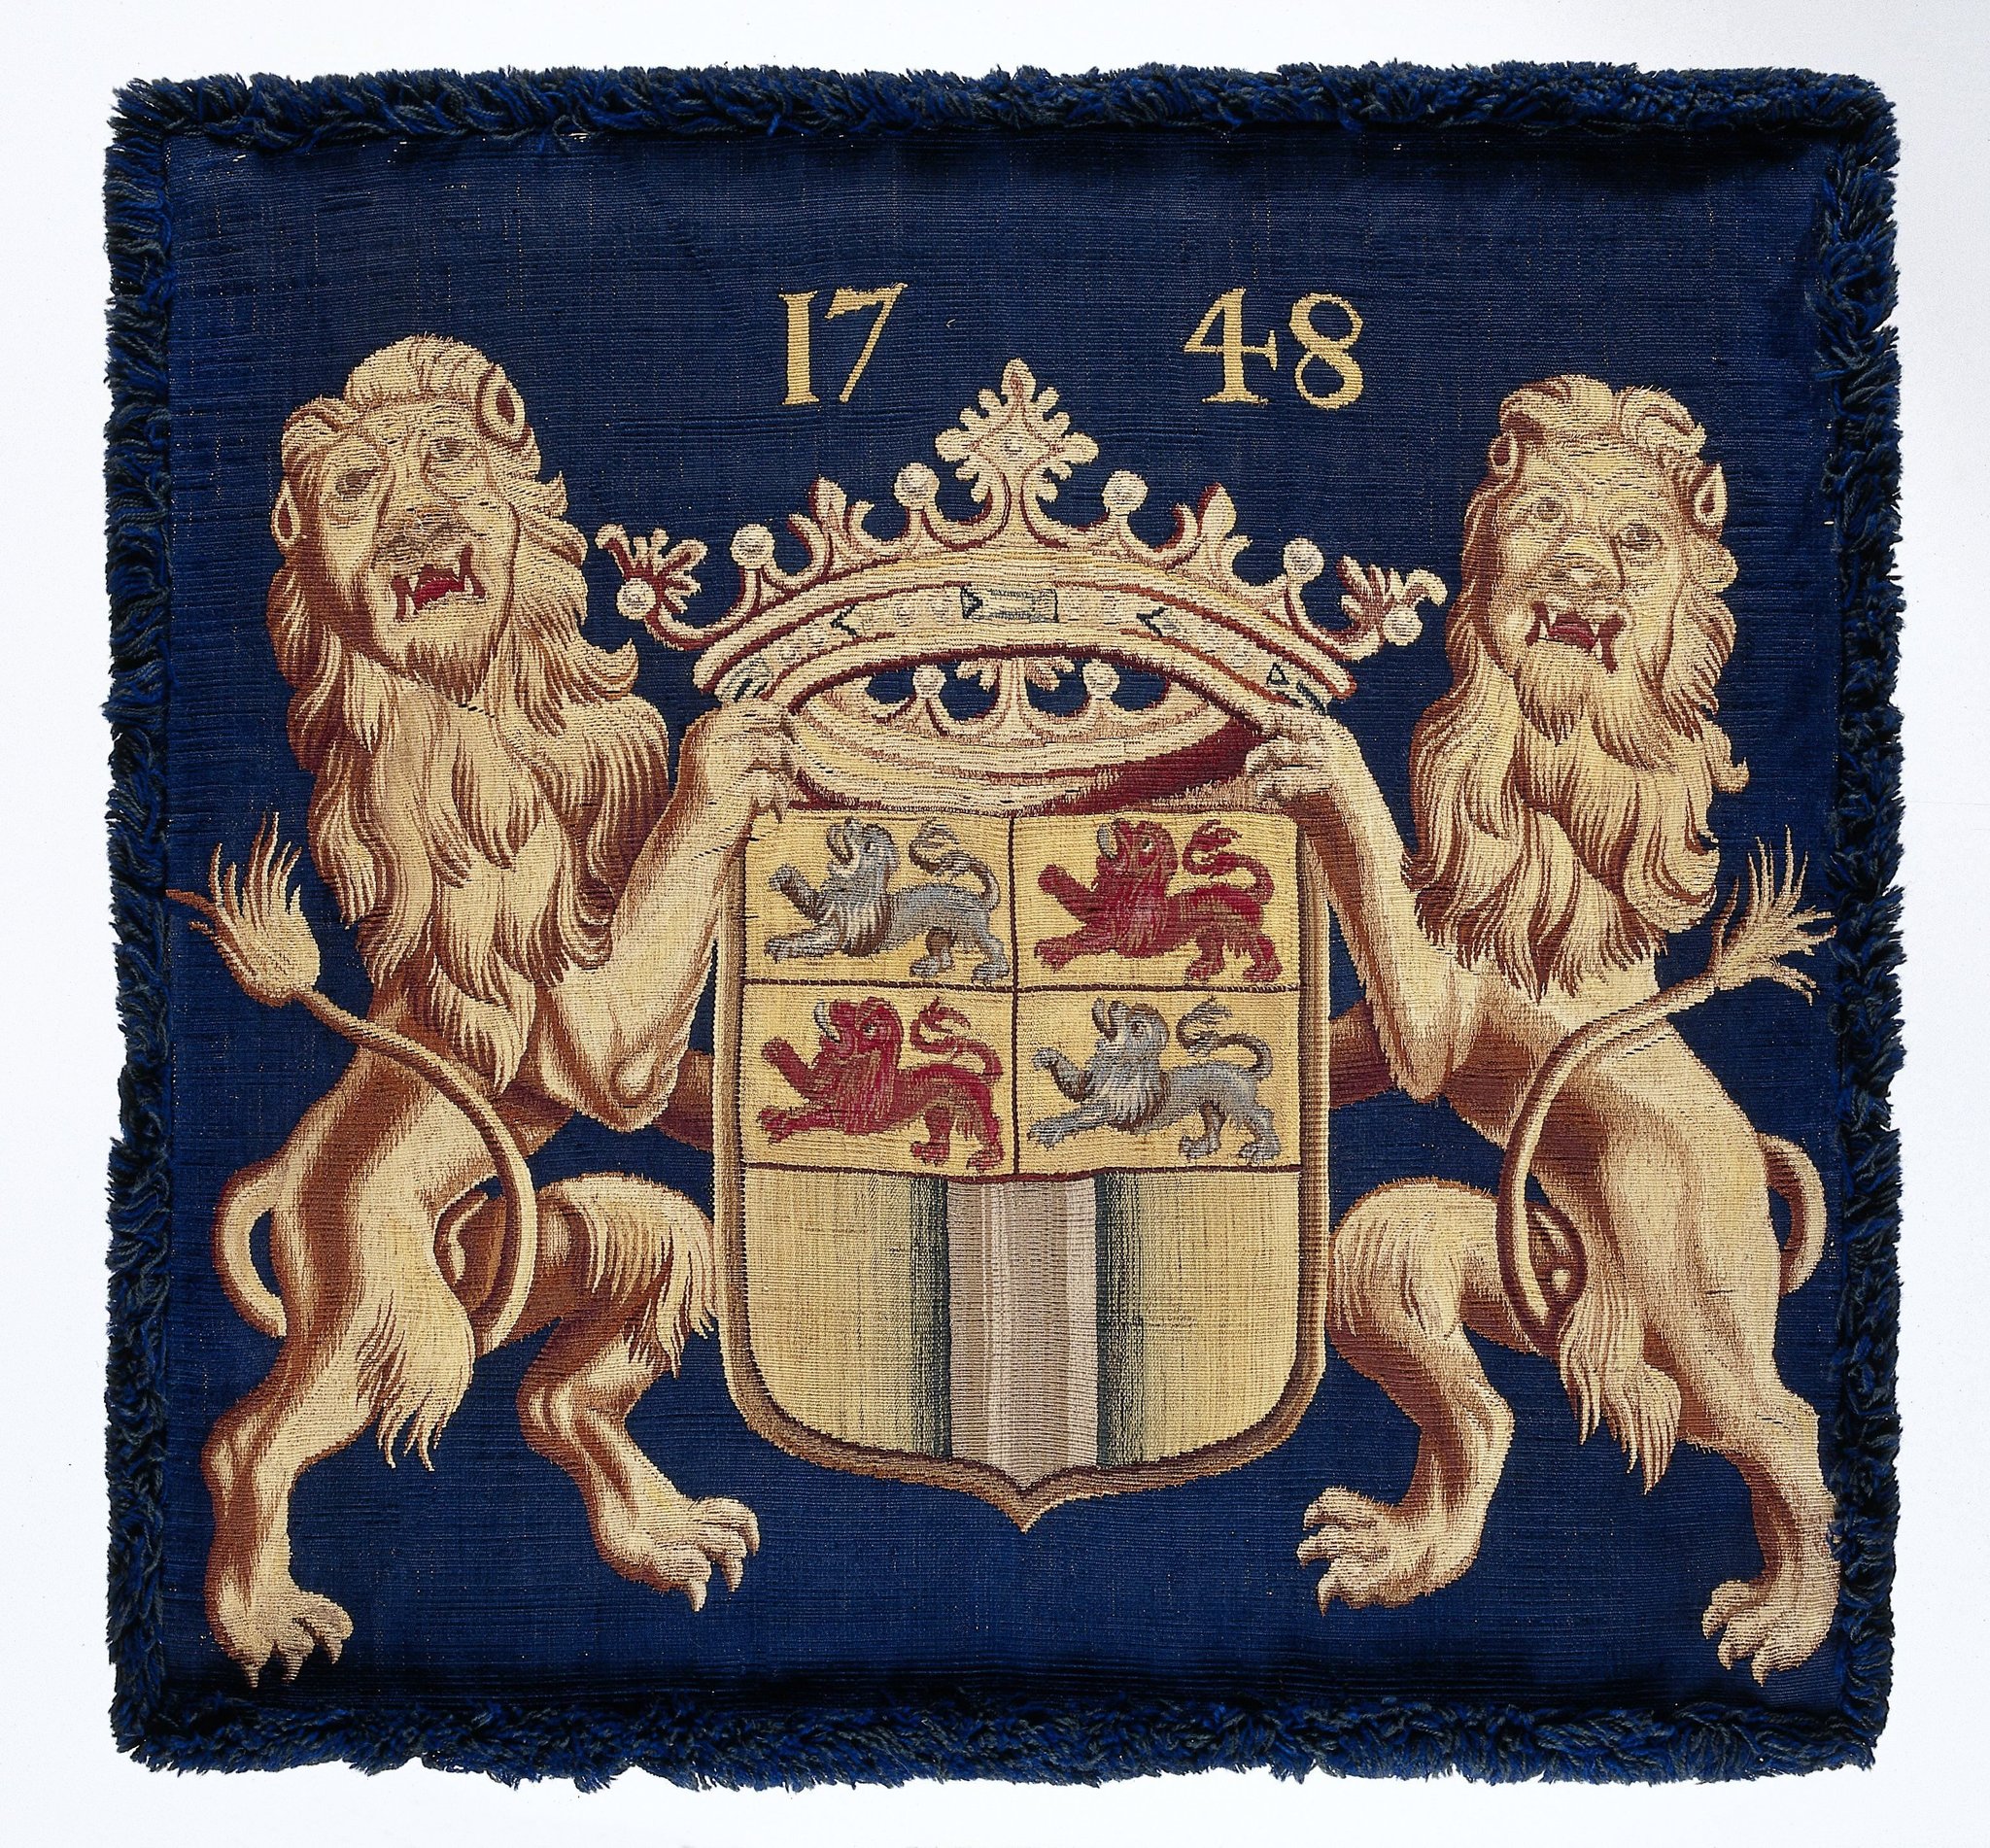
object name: pillow sham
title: Kussenovertrek met het stadswapen van Rotterdam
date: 1748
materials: silk, wool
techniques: tapestry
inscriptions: date: ‘1748’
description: Kussenblad van een magistratenkussen van tapijtweefsel met het stadswapen van Rotterdam en als schildhouders twee leeuwen. Boven het gekroonde wapenschild is het jaartal 1748 aangebracht.